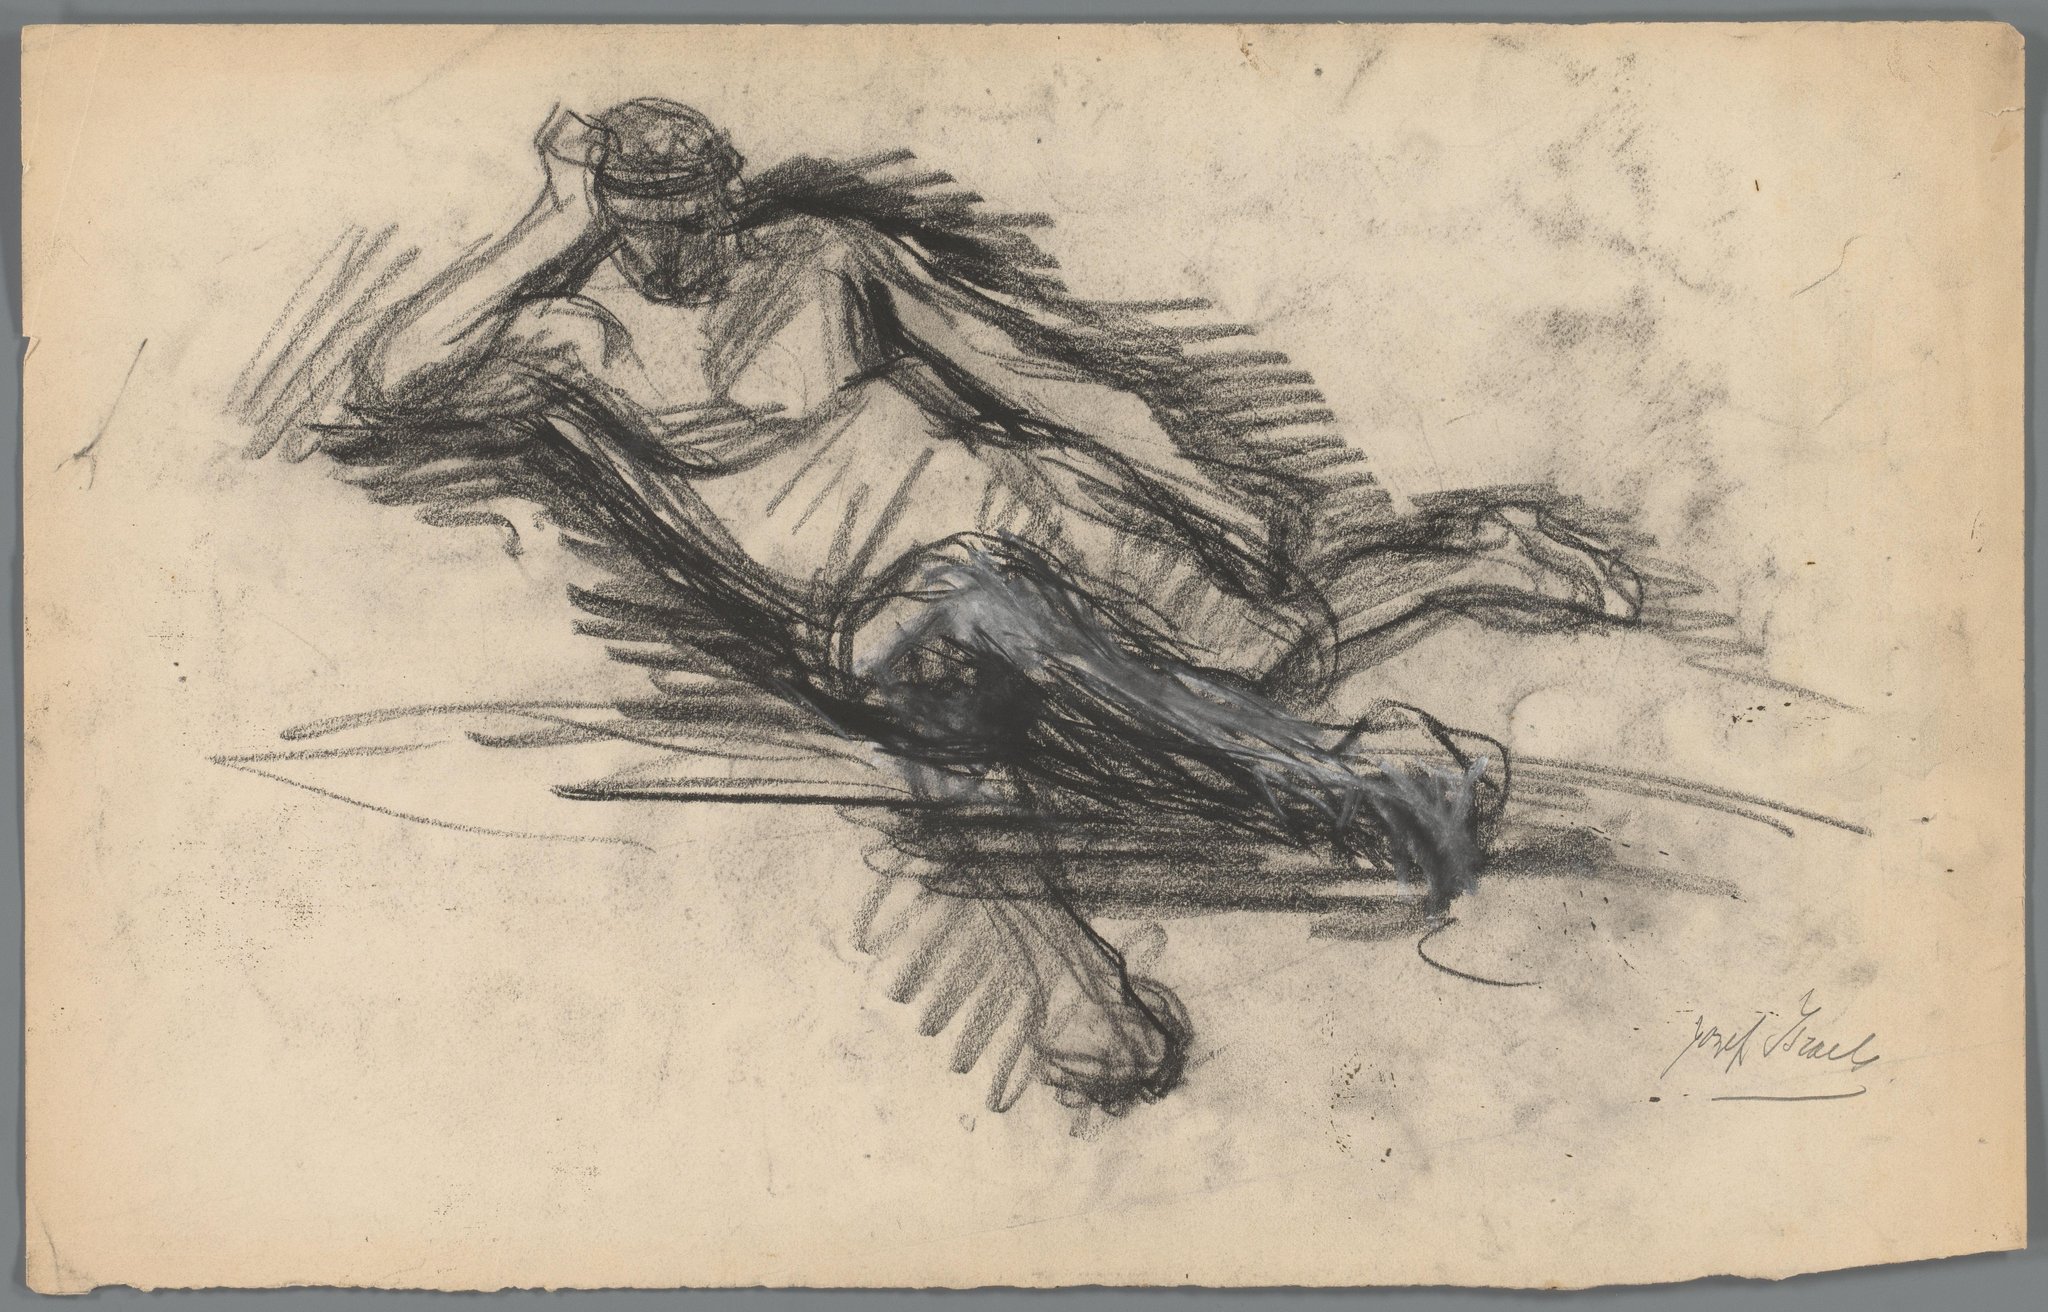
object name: drawing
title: Liggende Saul, het hoofd ondersteunend met de rechterhand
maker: jozef israëls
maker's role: draughtsman, painter, print maker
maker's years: 1824-1911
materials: chalk, paper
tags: story of saul, lying figure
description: Voorstudie voor het schilderij 'David en Saul' dat zich in het Groninger Museum bevindt.